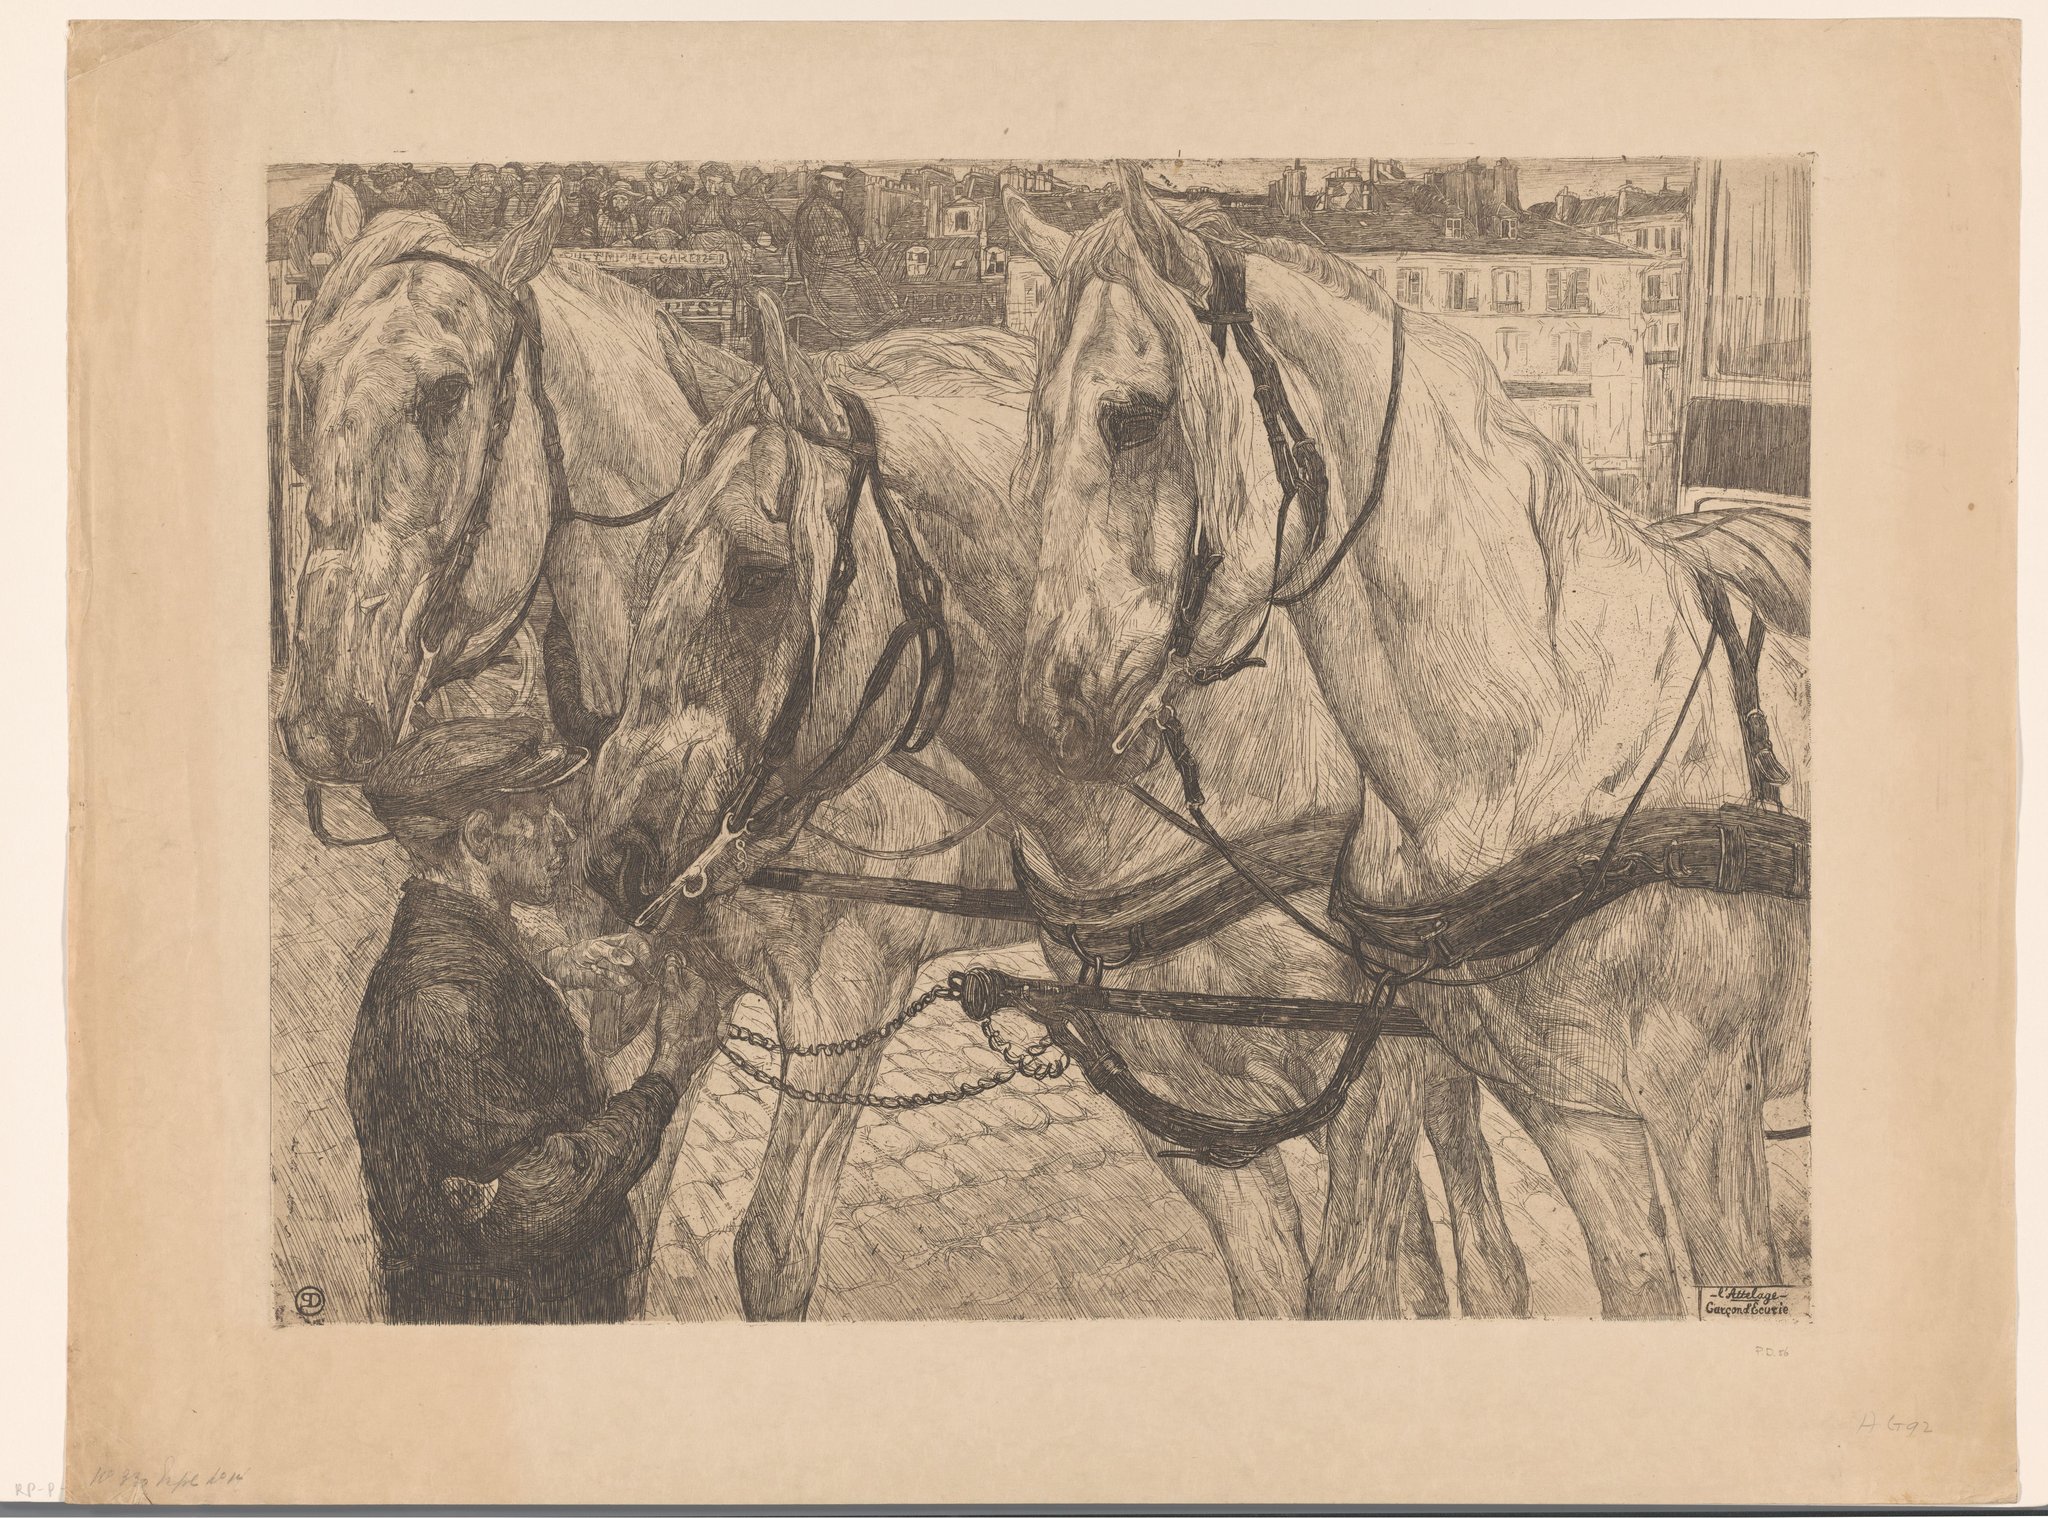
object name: print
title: L'Attelage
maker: pieter dupont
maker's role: draughtsman, print maker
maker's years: 1870-1911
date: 1896-1897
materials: paper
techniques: etching, intaglio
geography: amsterdam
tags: horse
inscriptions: collector's mark: Lugt 2228